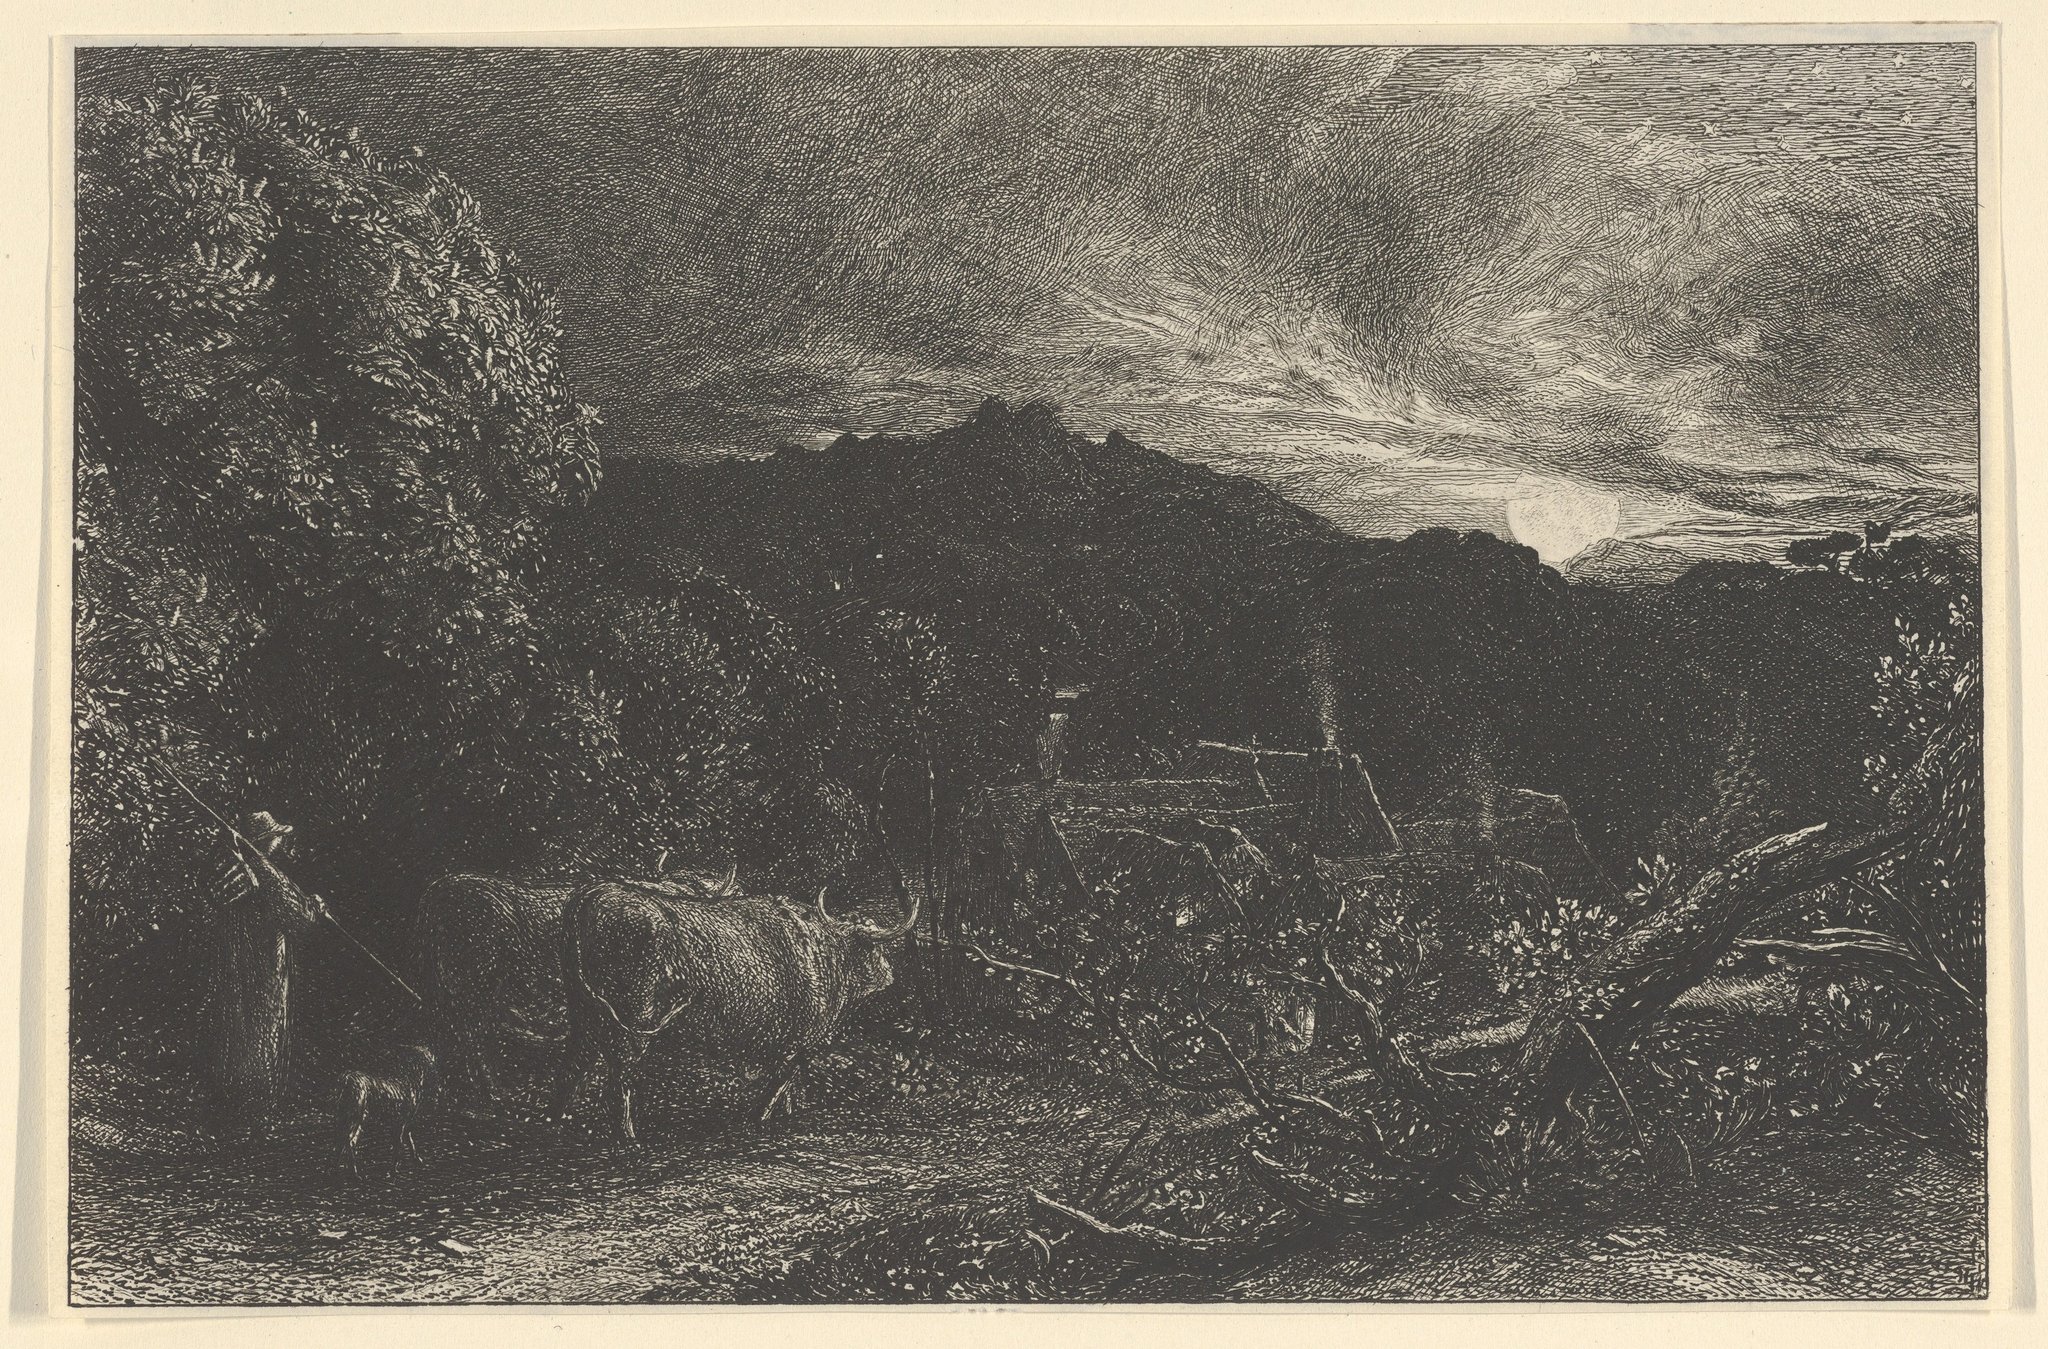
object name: print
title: The Weary Ploughman, or The Herdsman, or Tardus Bubulcus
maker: samuel palmer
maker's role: artist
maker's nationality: british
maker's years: 1805-1881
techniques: etching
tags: animals,men,agriculture,trees